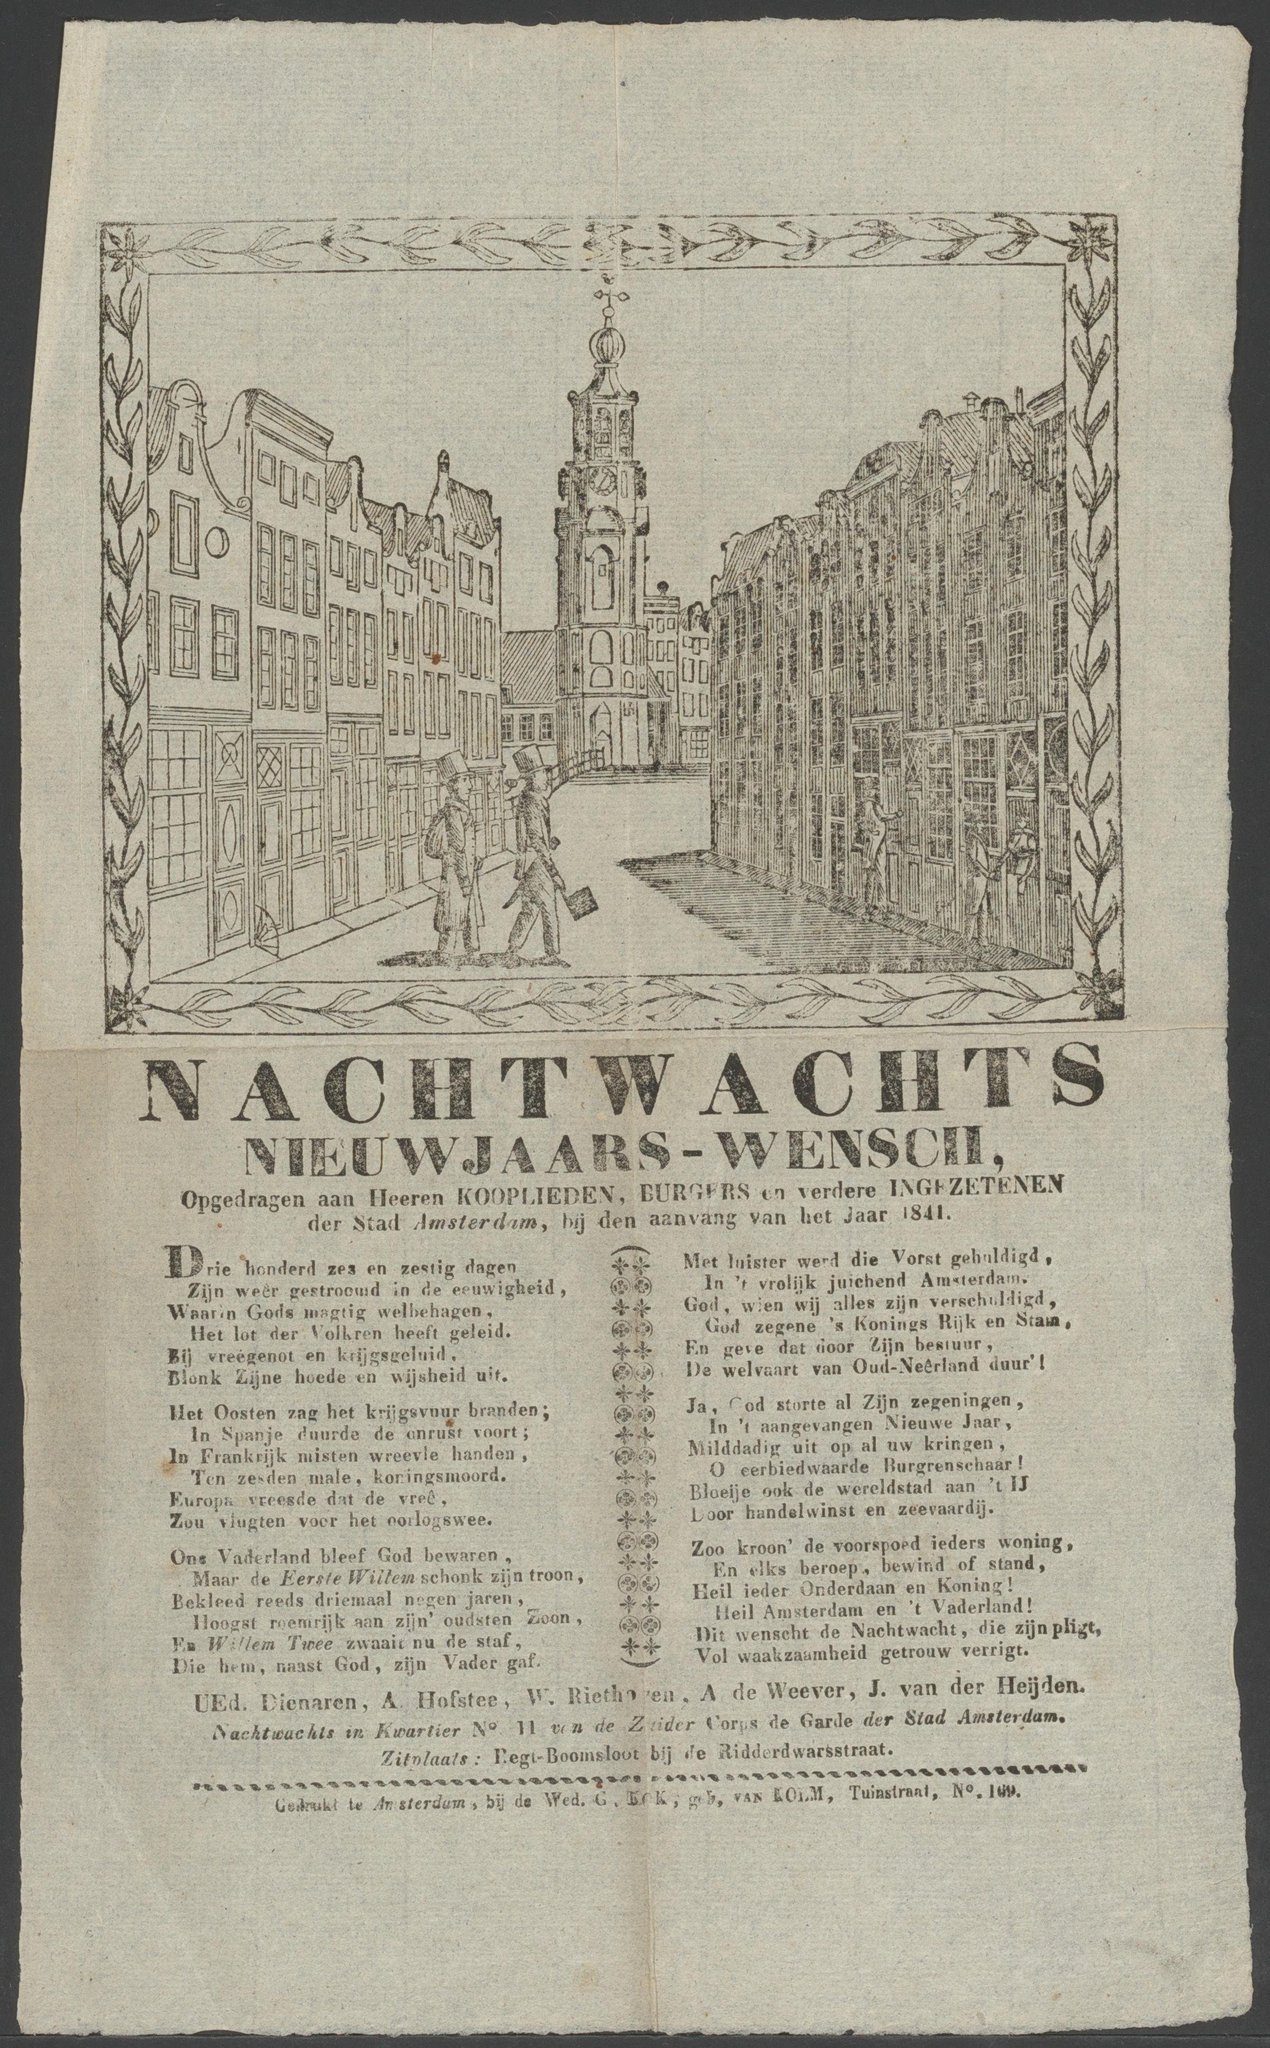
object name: print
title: Nachtwachts Nieuwjaars-wensch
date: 1840-1841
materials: paper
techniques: letterpress printing, engraving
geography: amsterdam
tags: night patrol, canals, waters (in city), amsterdam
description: Nieuwjaarswens van de Amsterdamse nachtwacht (ratelwacht) voor het jaar 1841. Twee leden van de nachtwacht lopend met een ratel door een straat (Reguliersbreestraat?) bij de Munt in Amsterdam. Met een vers in twee kolommen. Namens de nachtwacht in kwartier No. 11 van de Zuider Corps de Garde der stad Amsterdam: A. Hofstee, W. Riethoven, A. de Weever en J. van der Heijden. Onderwerpsrubrieken binnen de Atlas Zeden en Gewoonten: Zeden en gewoonten in engeren zin, Volksleven, Volksbladen, Nieuwjaars- en Kerstwenschen, Amsterdam.